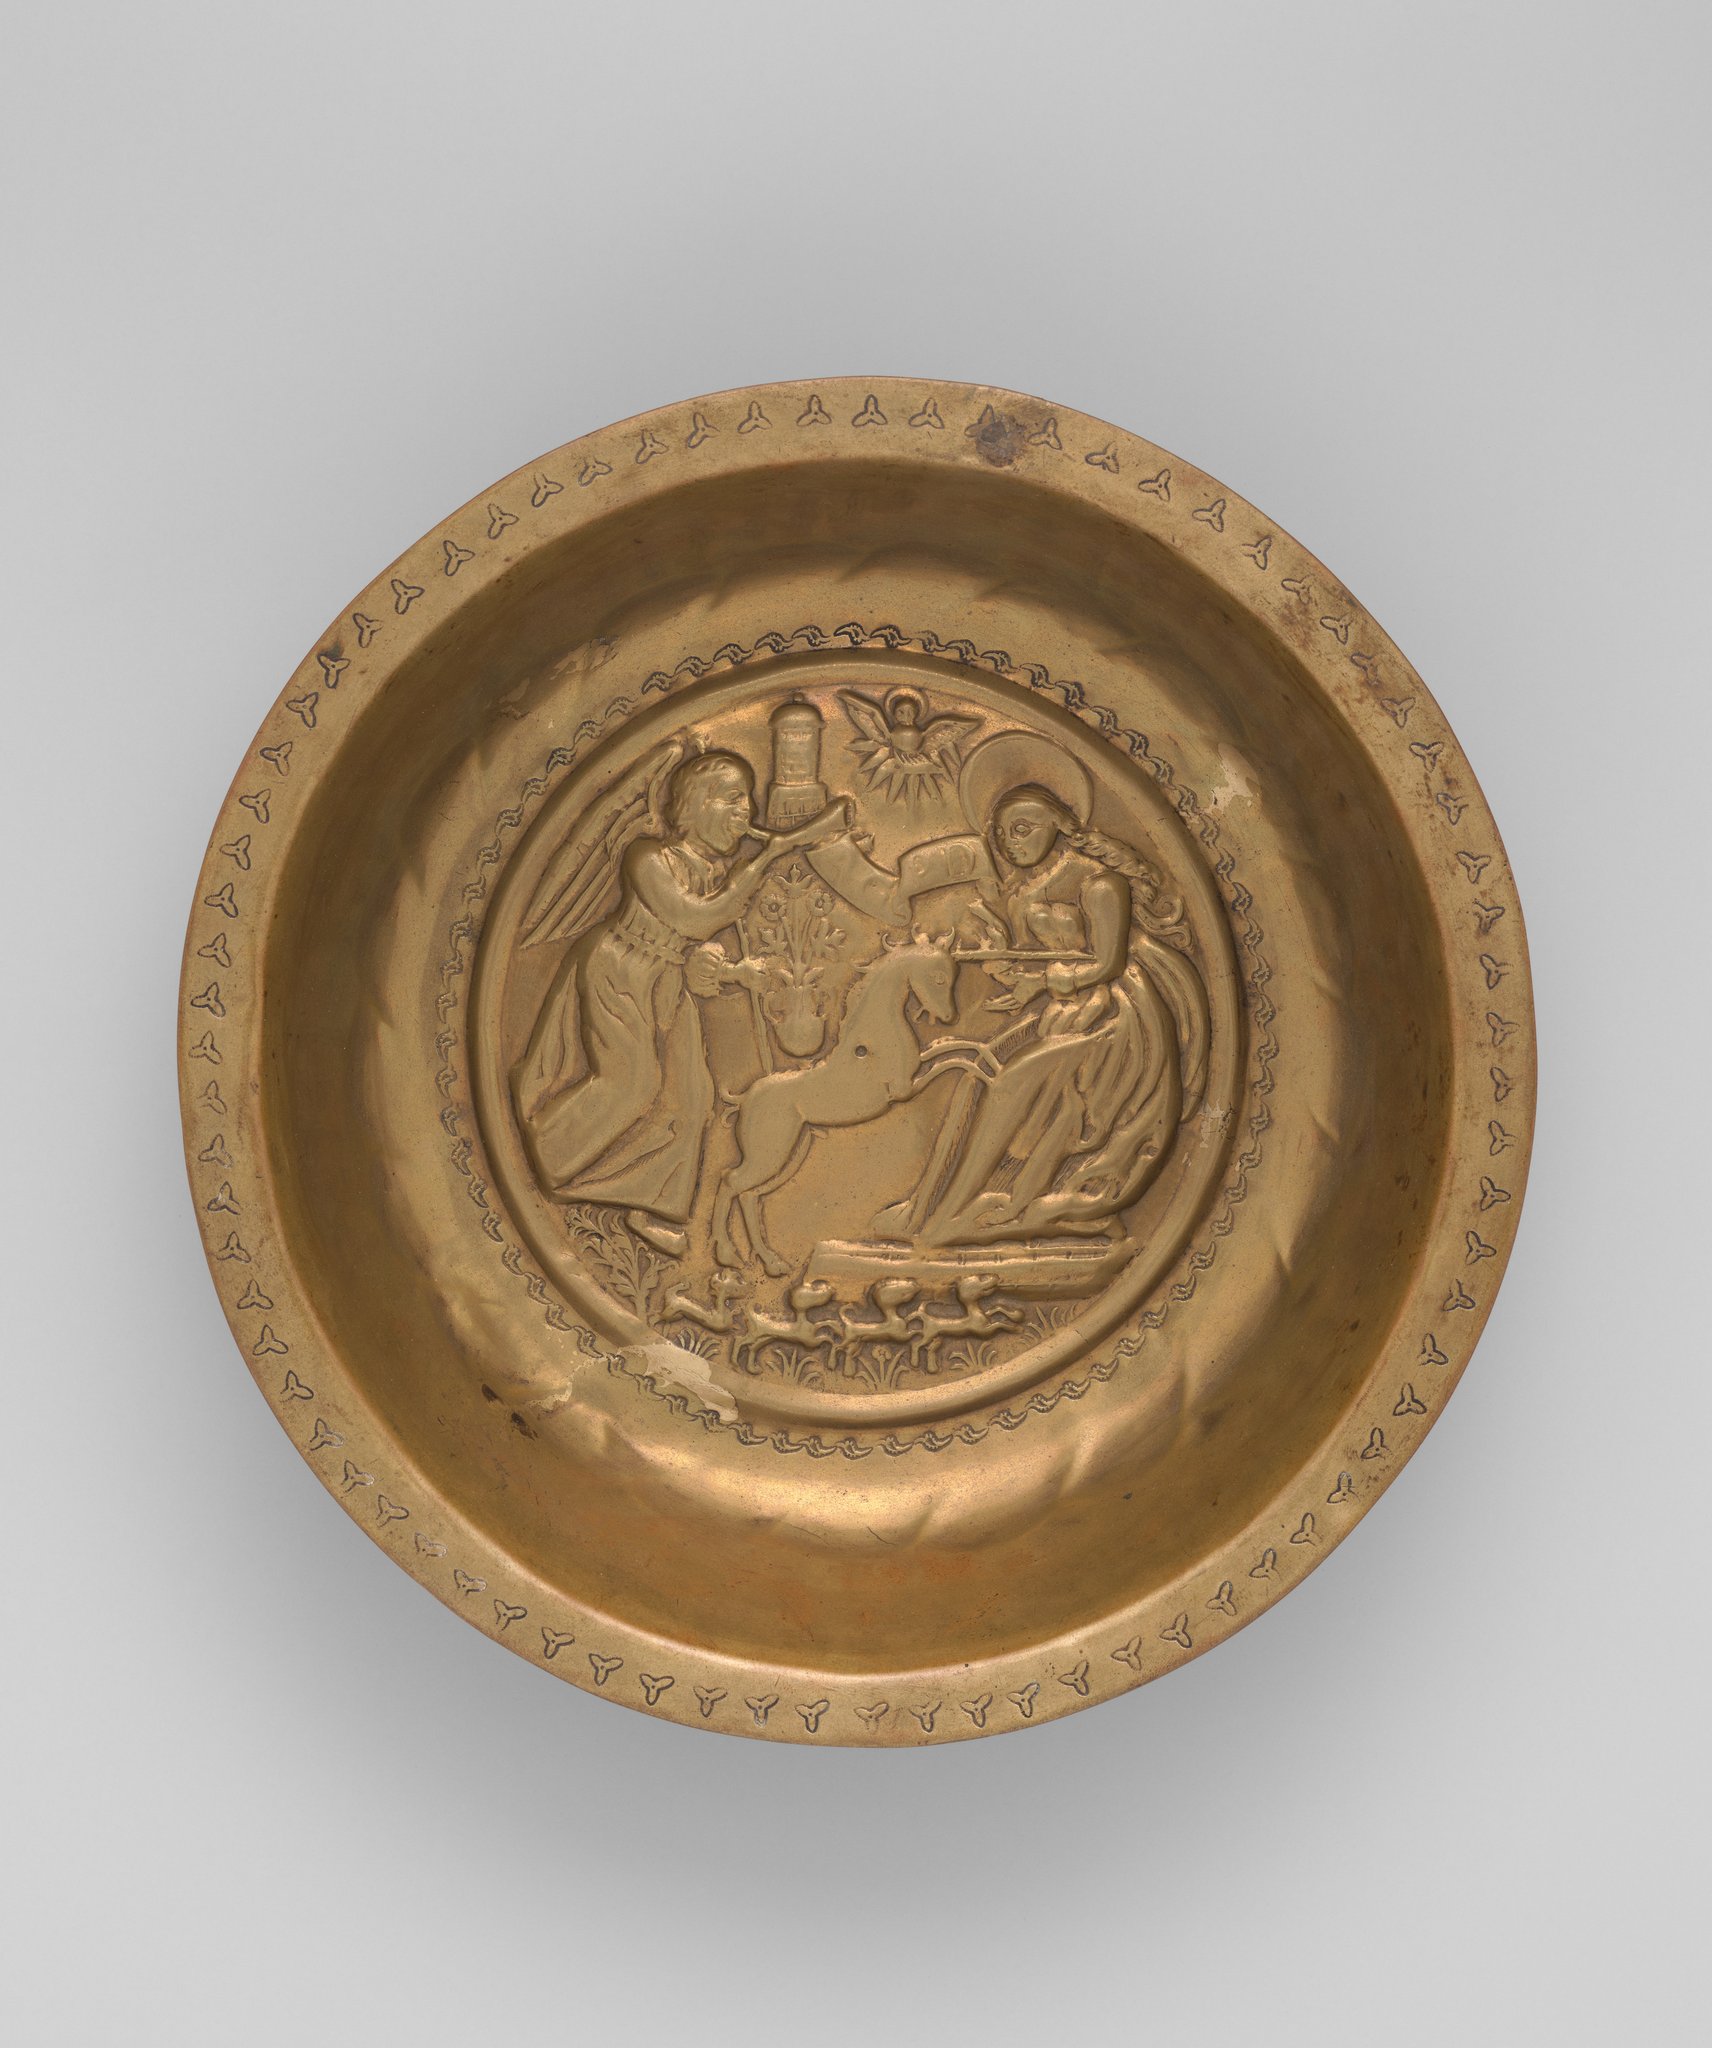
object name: bowl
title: Mystic Chase of the Unicorn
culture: german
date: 1467-1500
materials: brass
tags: unicorns,angels,virgin mary